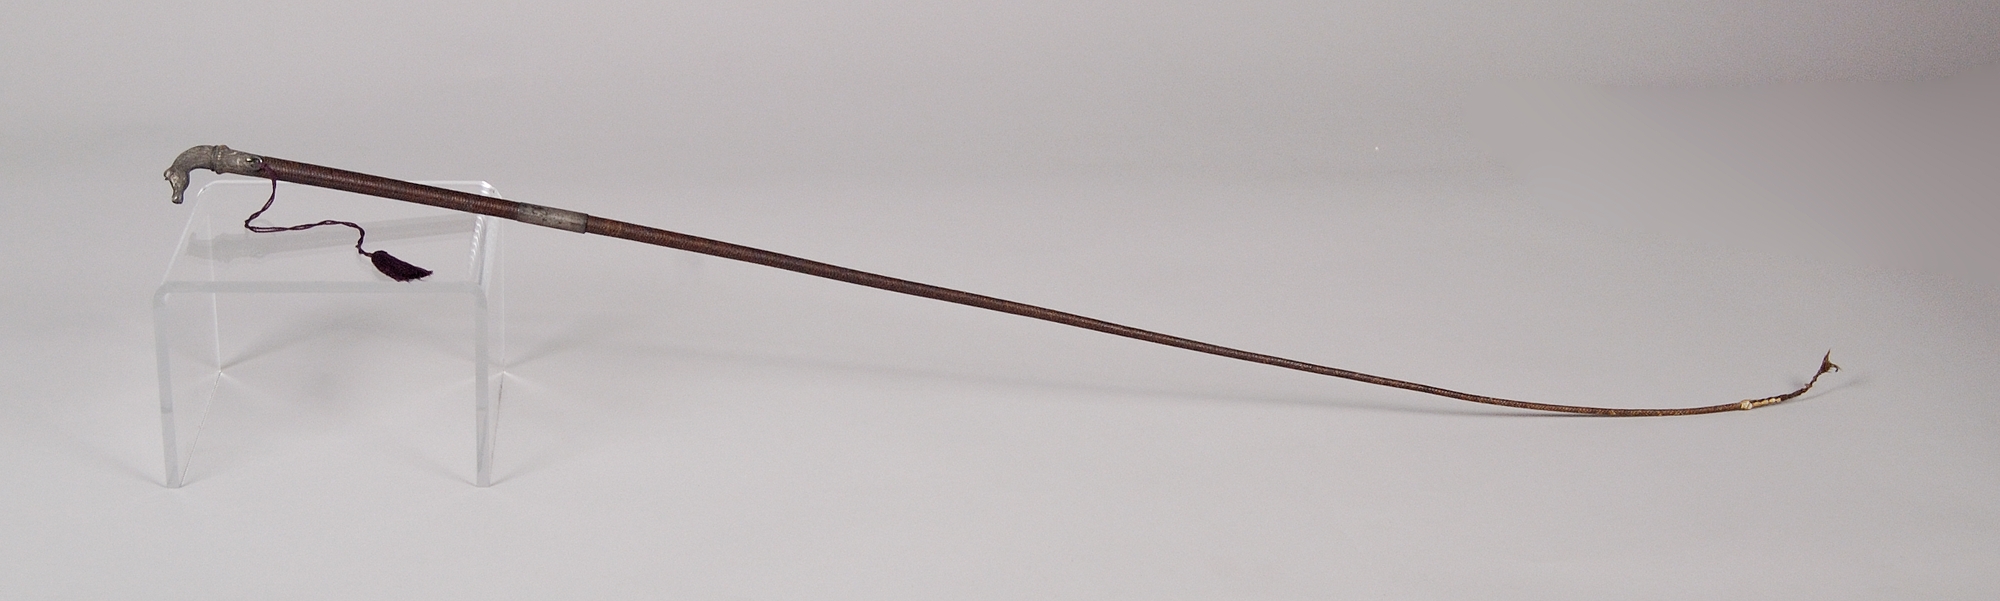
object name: riding crop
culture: american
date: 1885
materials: hair, leather, linen, metal, silk